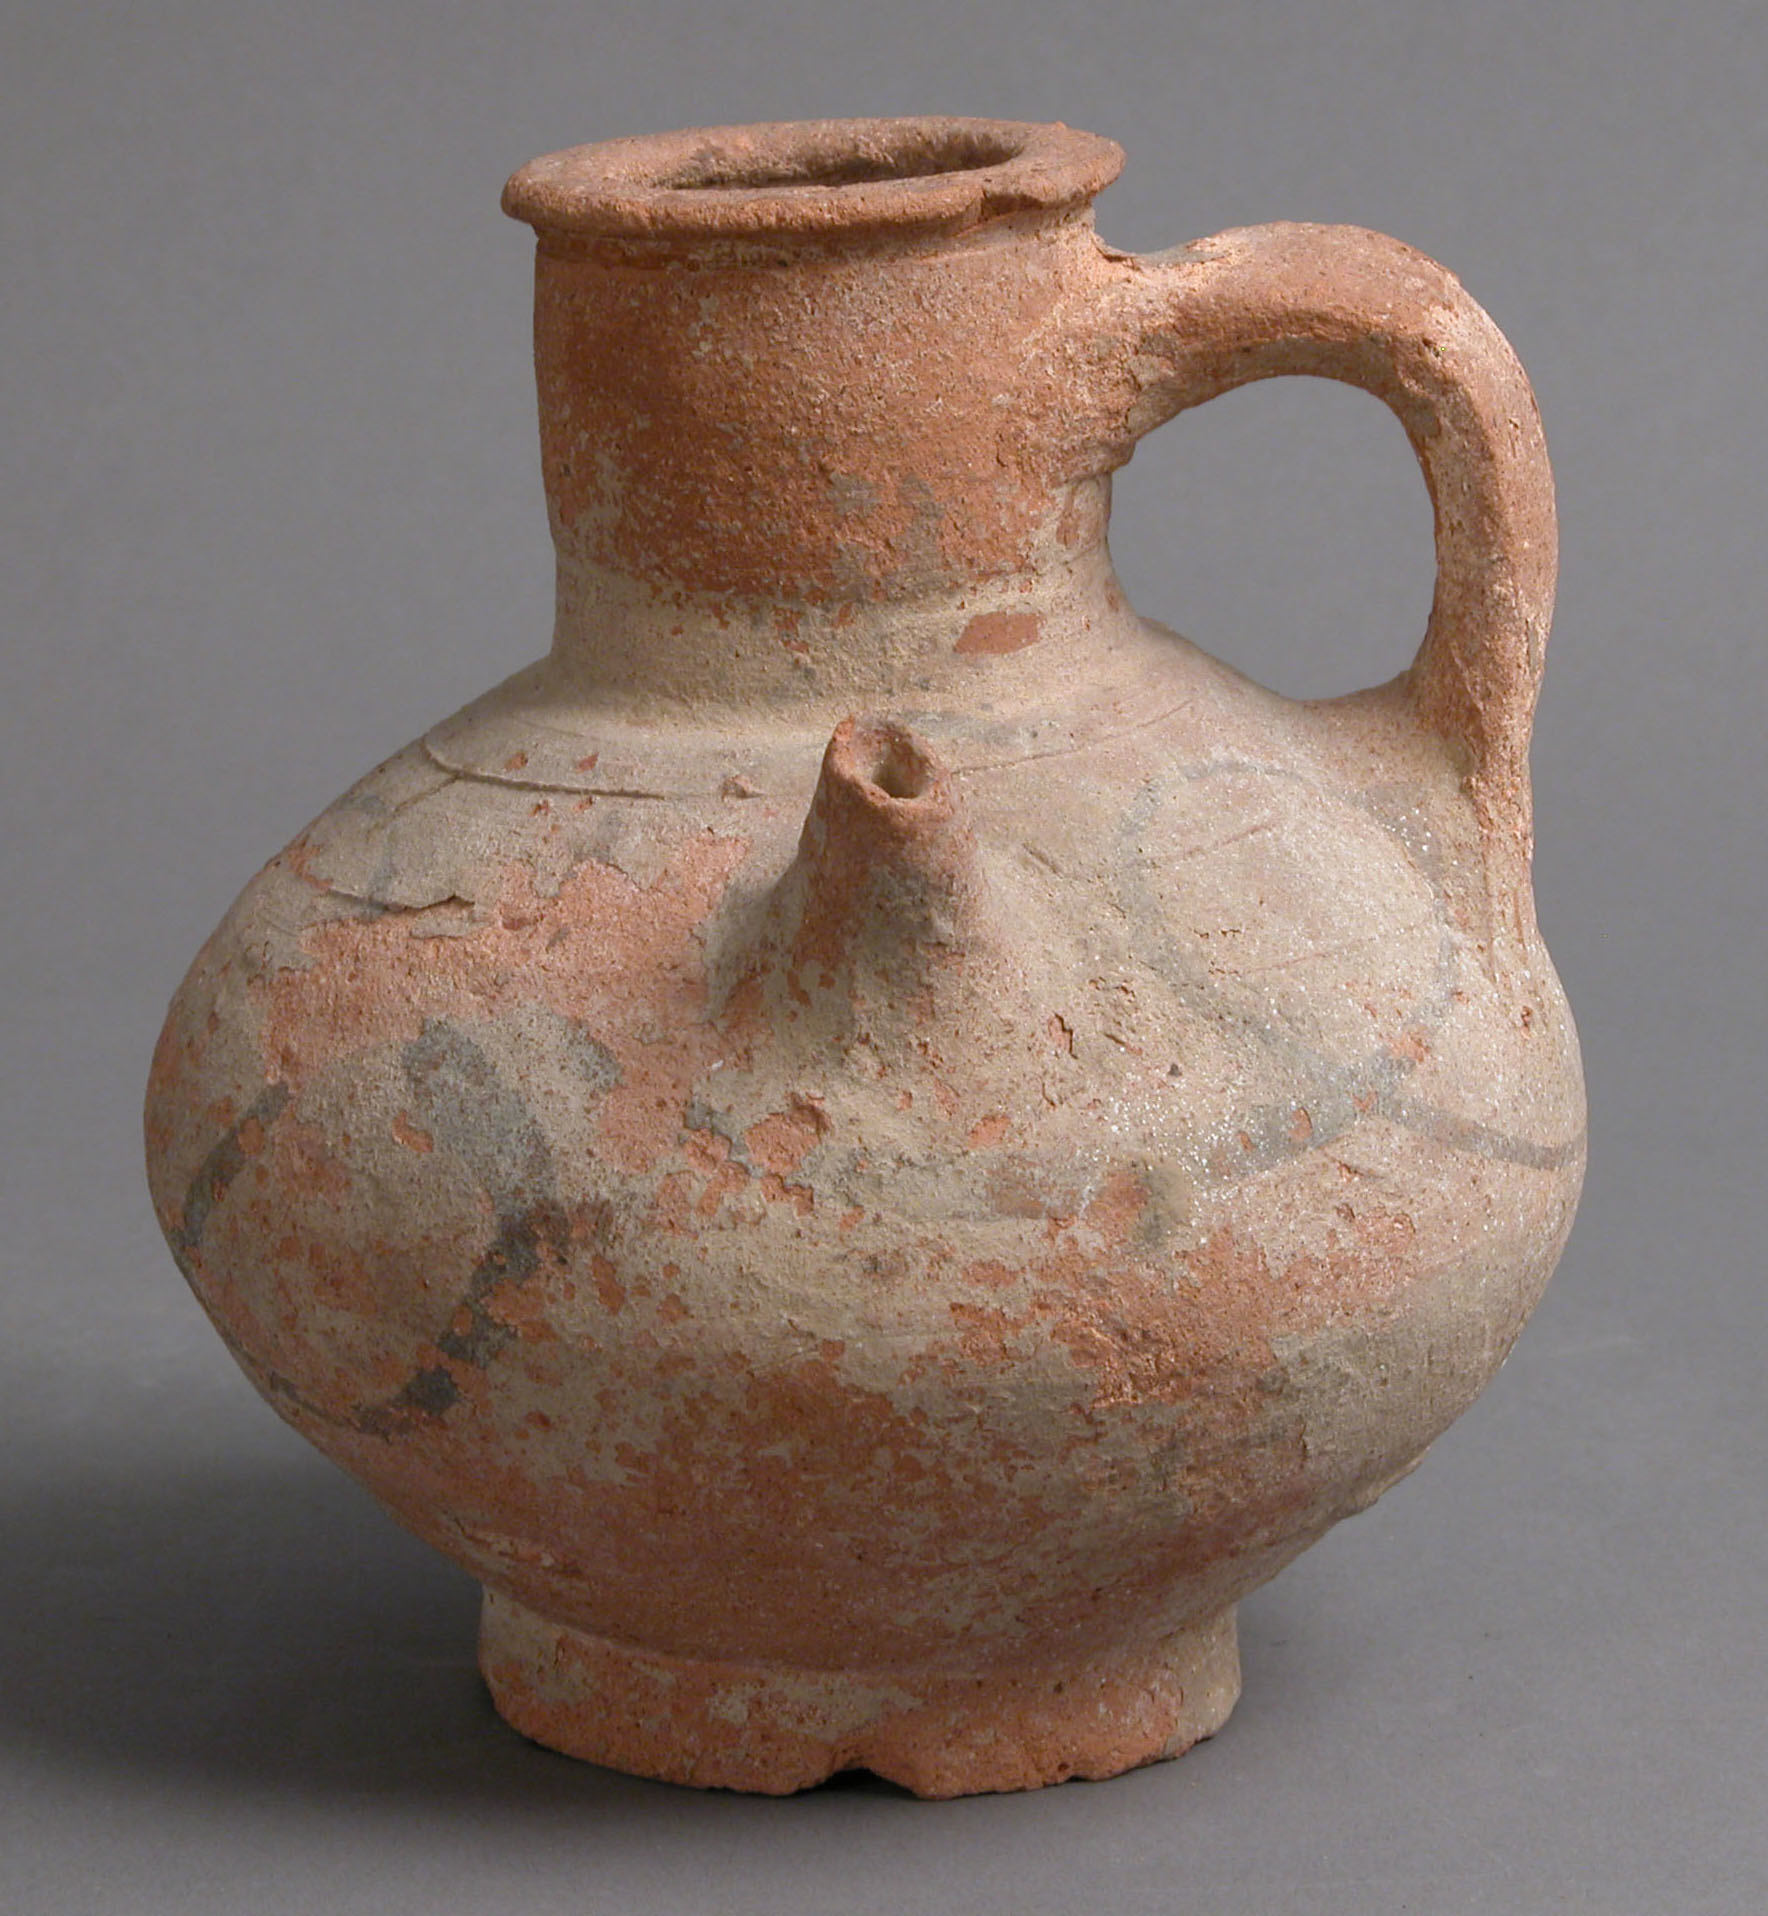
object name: jug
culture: coptic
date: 301-700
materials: earthenware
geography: egypt